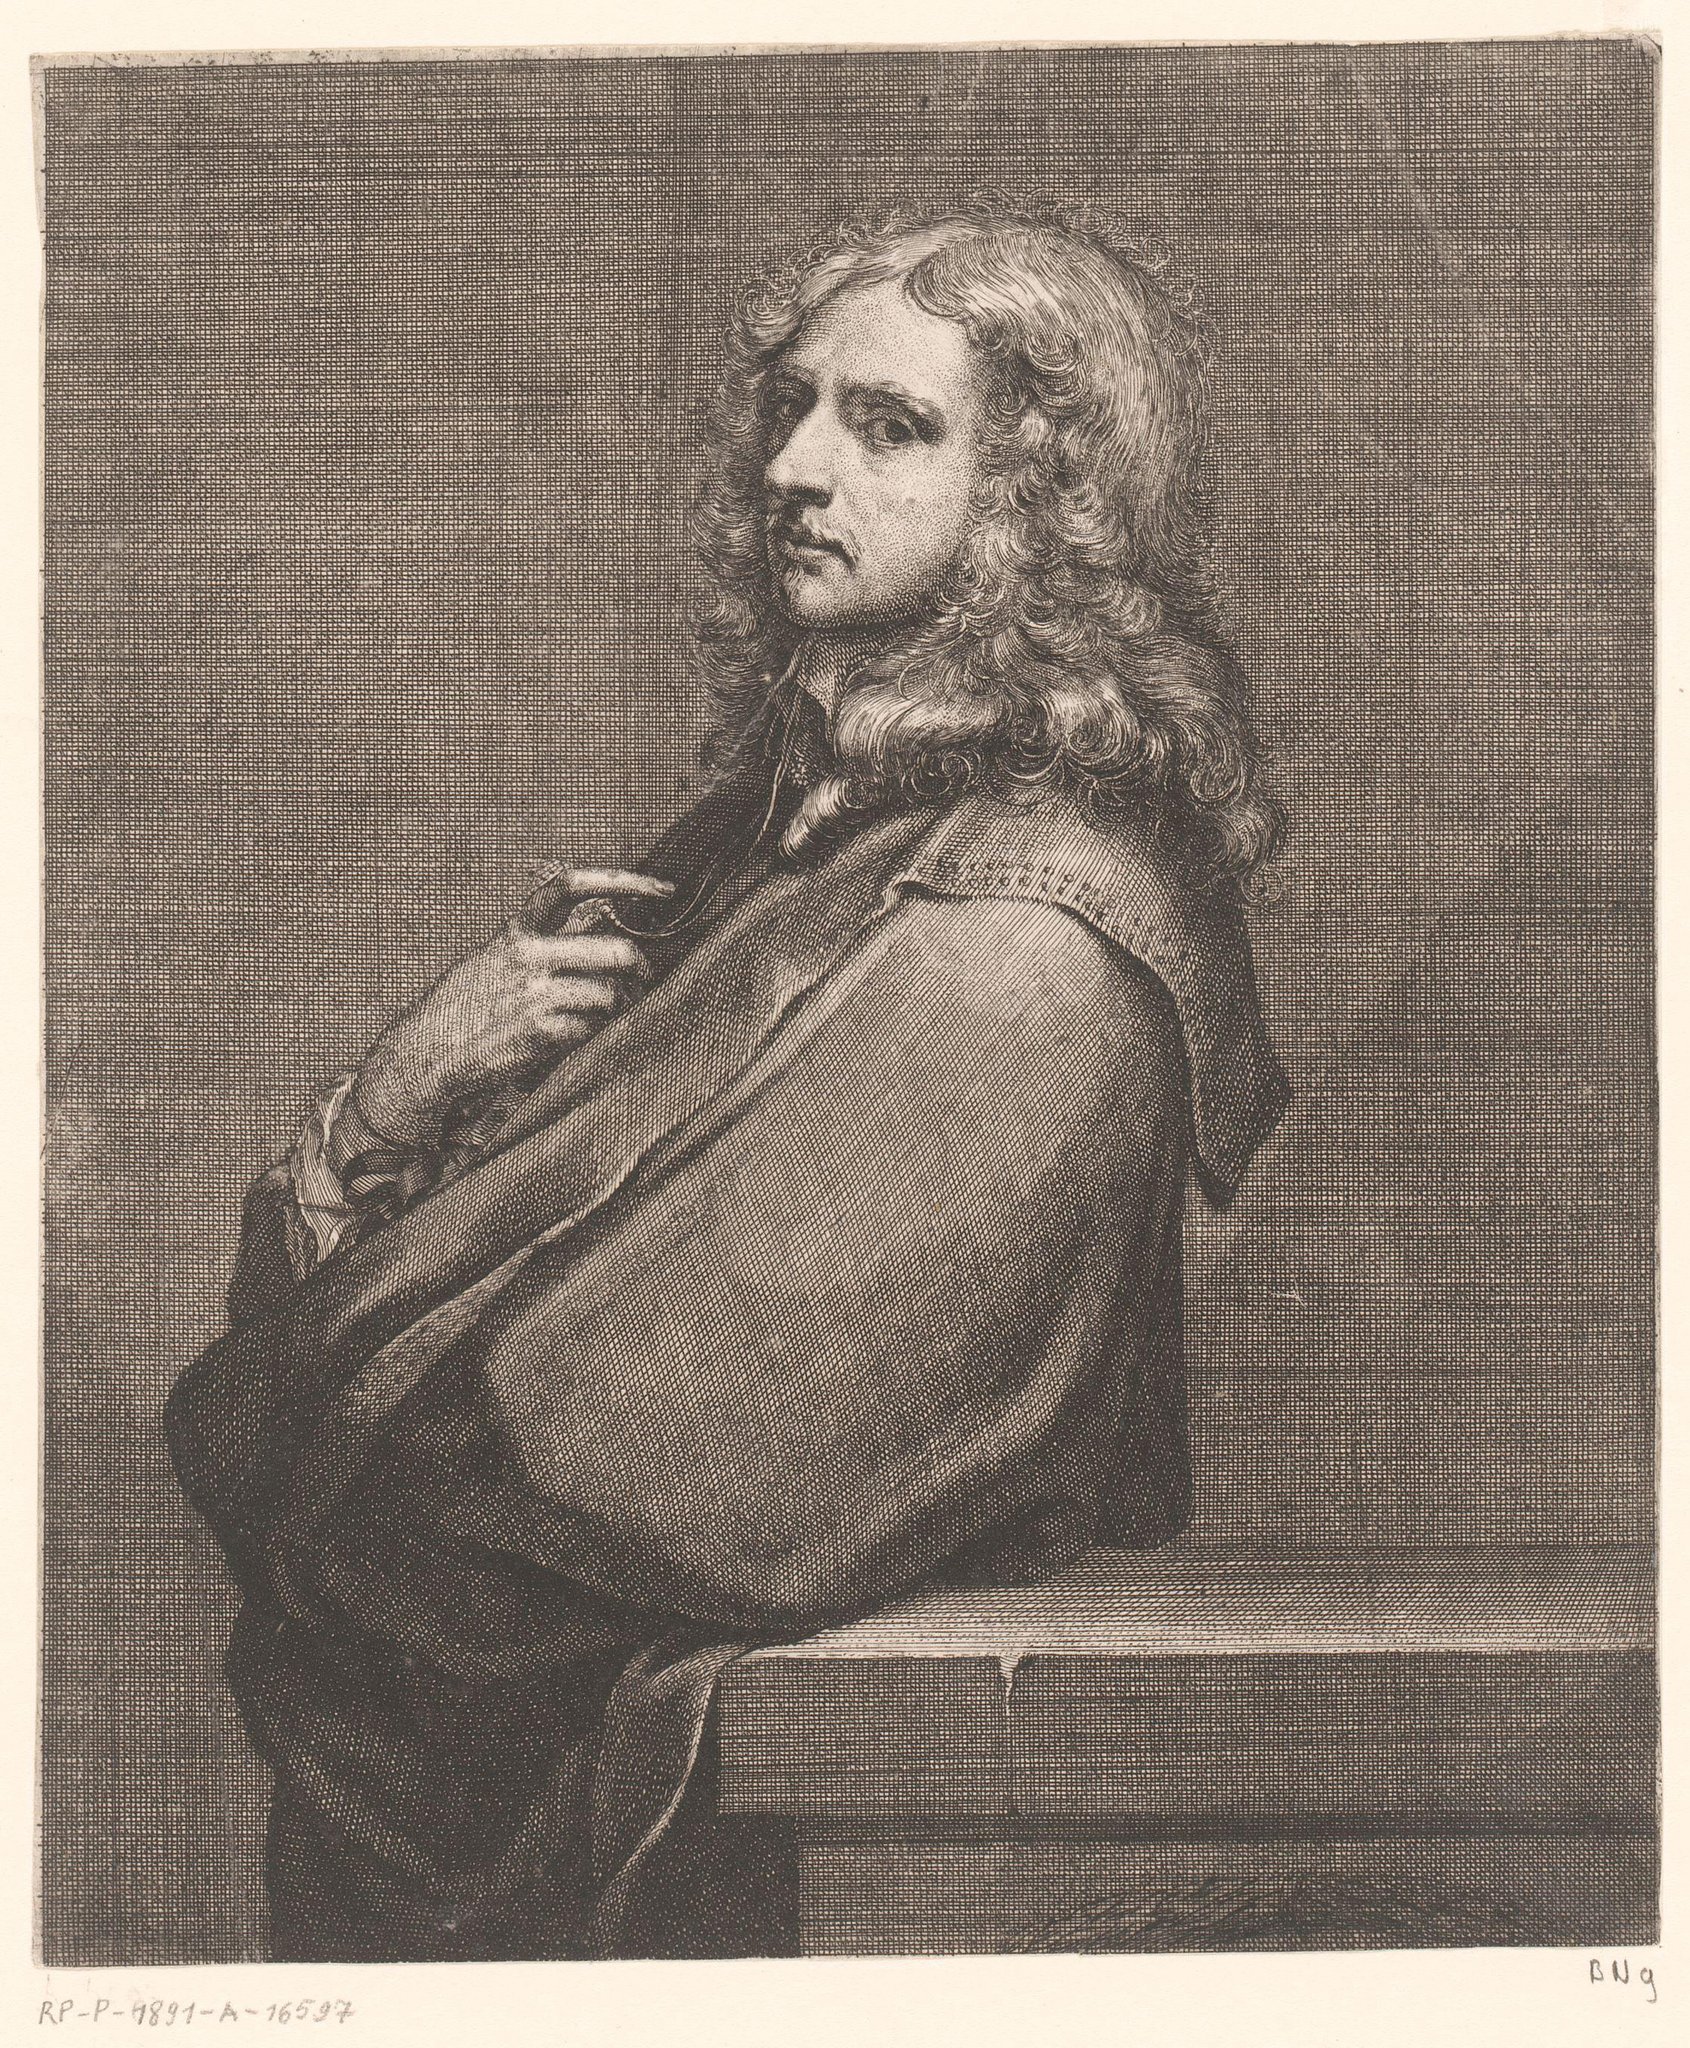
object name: print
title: Portret van Louis du Guernier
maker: samuel bernard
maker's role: print maker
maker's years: 1615-1687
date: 1634-1687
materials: paper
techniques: engraving, etching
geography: france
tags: paris, louis du guernier (i), portrait, self-portrait of painter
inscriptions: collector's mark: Lugt 2228